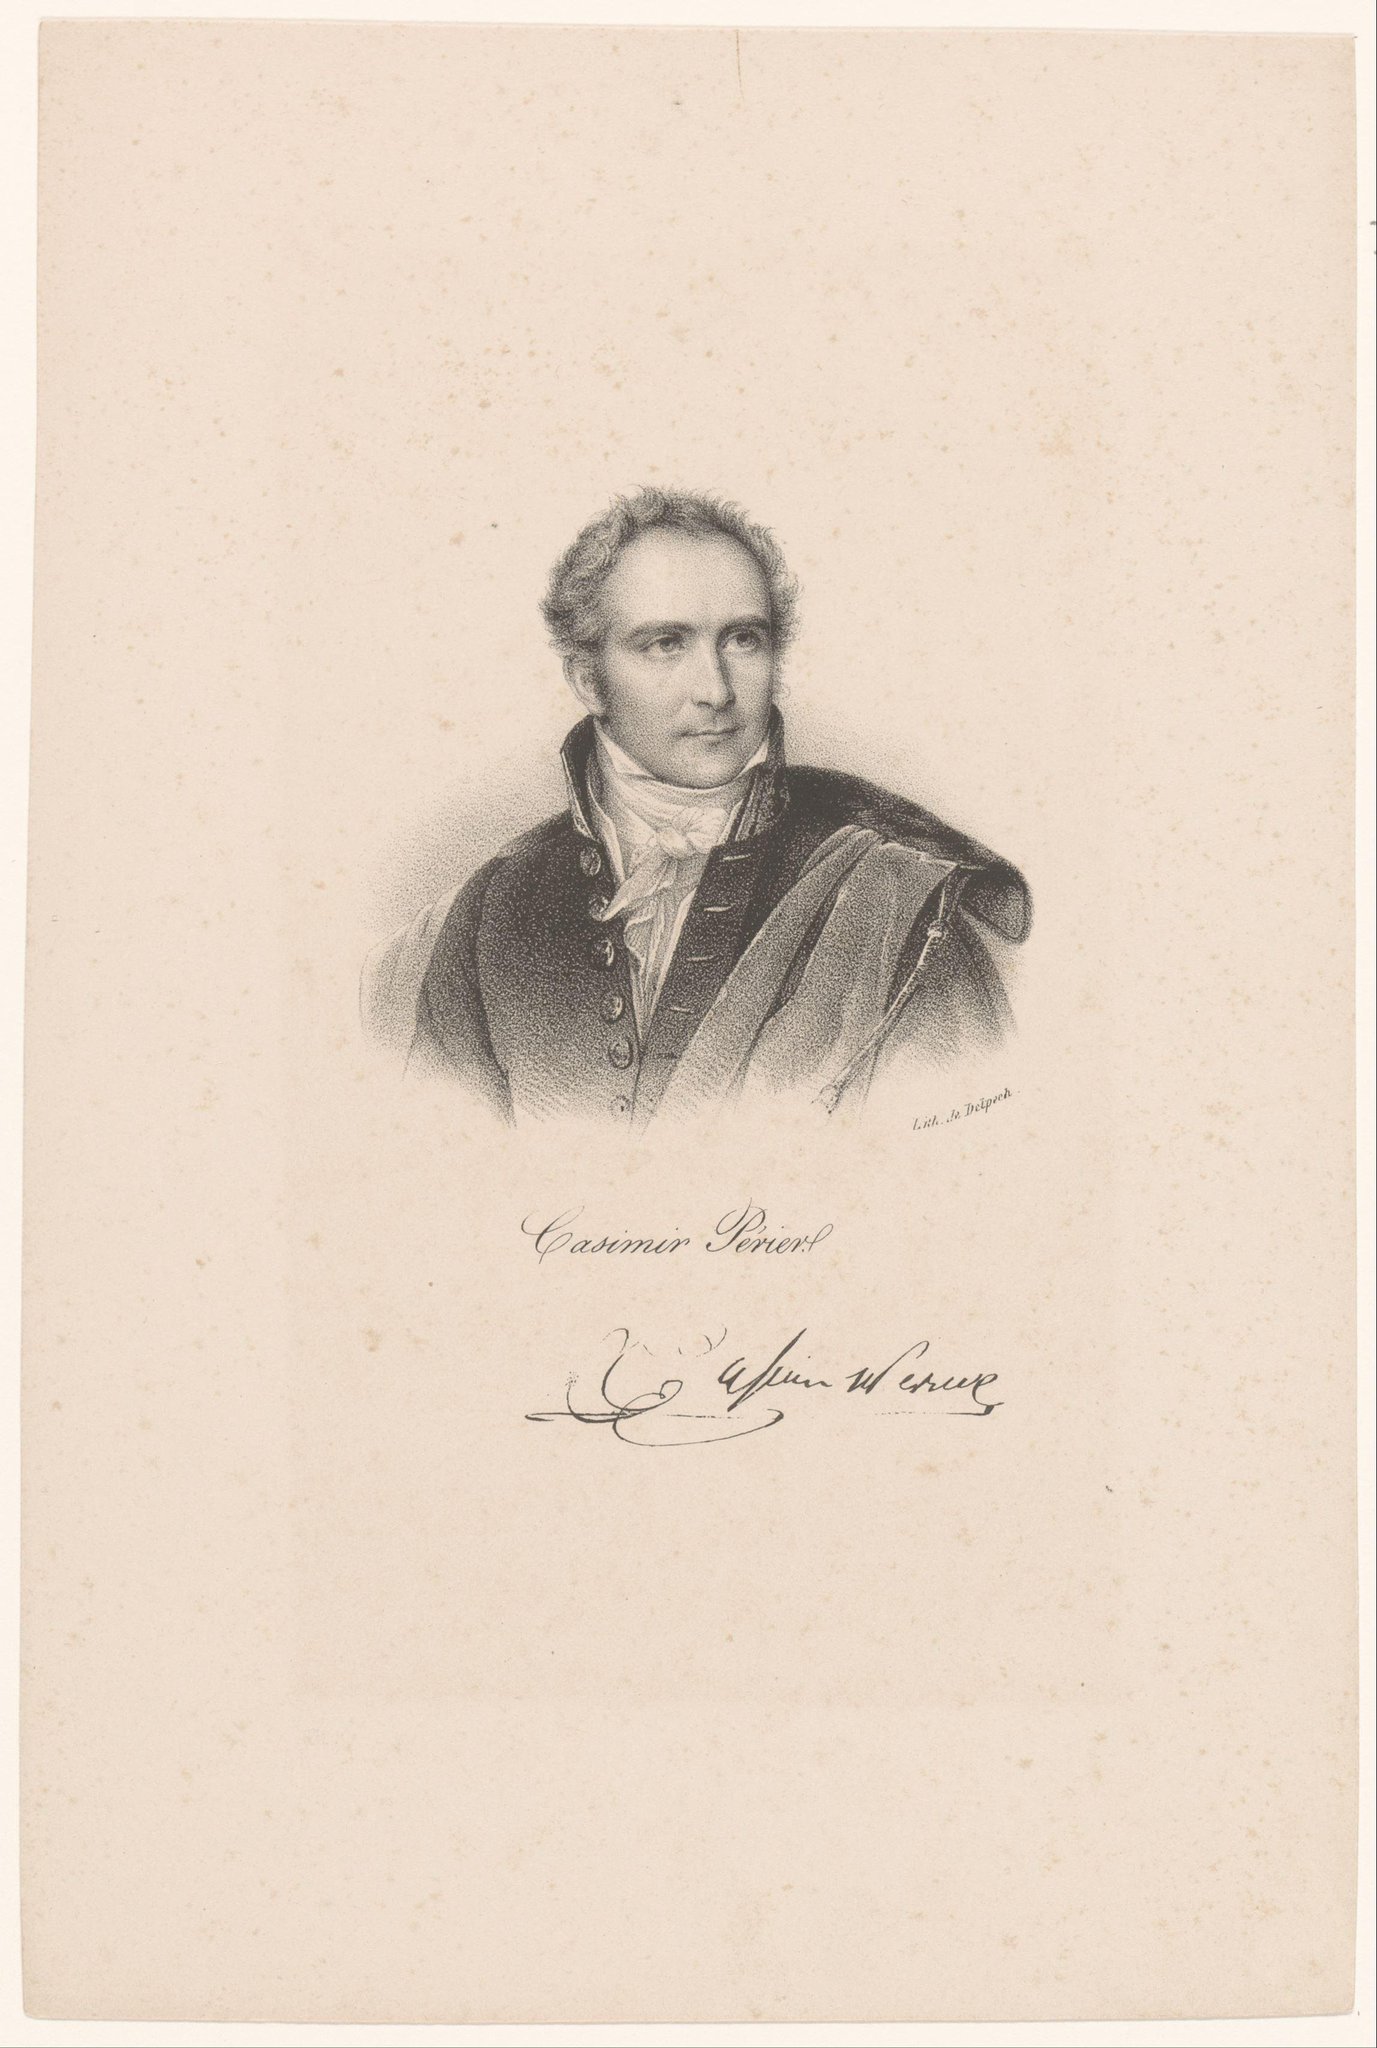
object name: print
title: Casimir Périer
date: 1818-1842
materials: paper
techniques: lithograph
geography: paris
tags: paris, politician, historical persons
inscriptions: collector's mark: Lugt 2228a